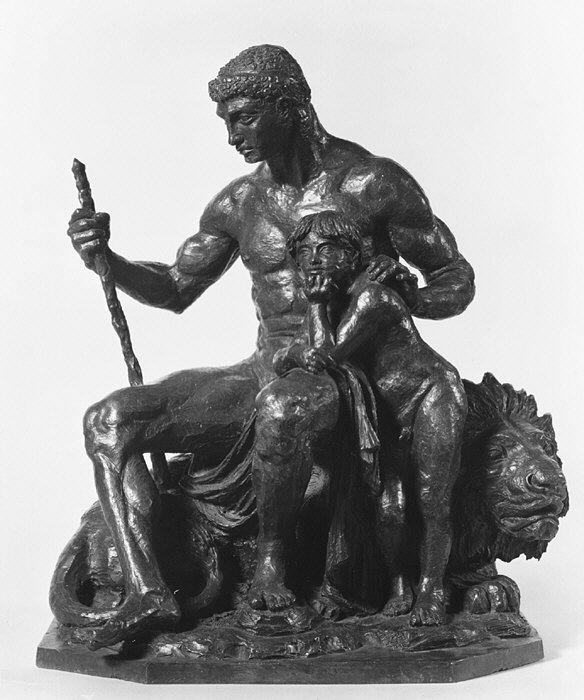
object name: statuette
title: Group Symbolic of Force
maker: antoine-louis barye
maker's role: artist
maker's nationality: french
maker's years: 1795-1875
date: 1801-1900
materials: bronze, patina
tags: boys,men,lions